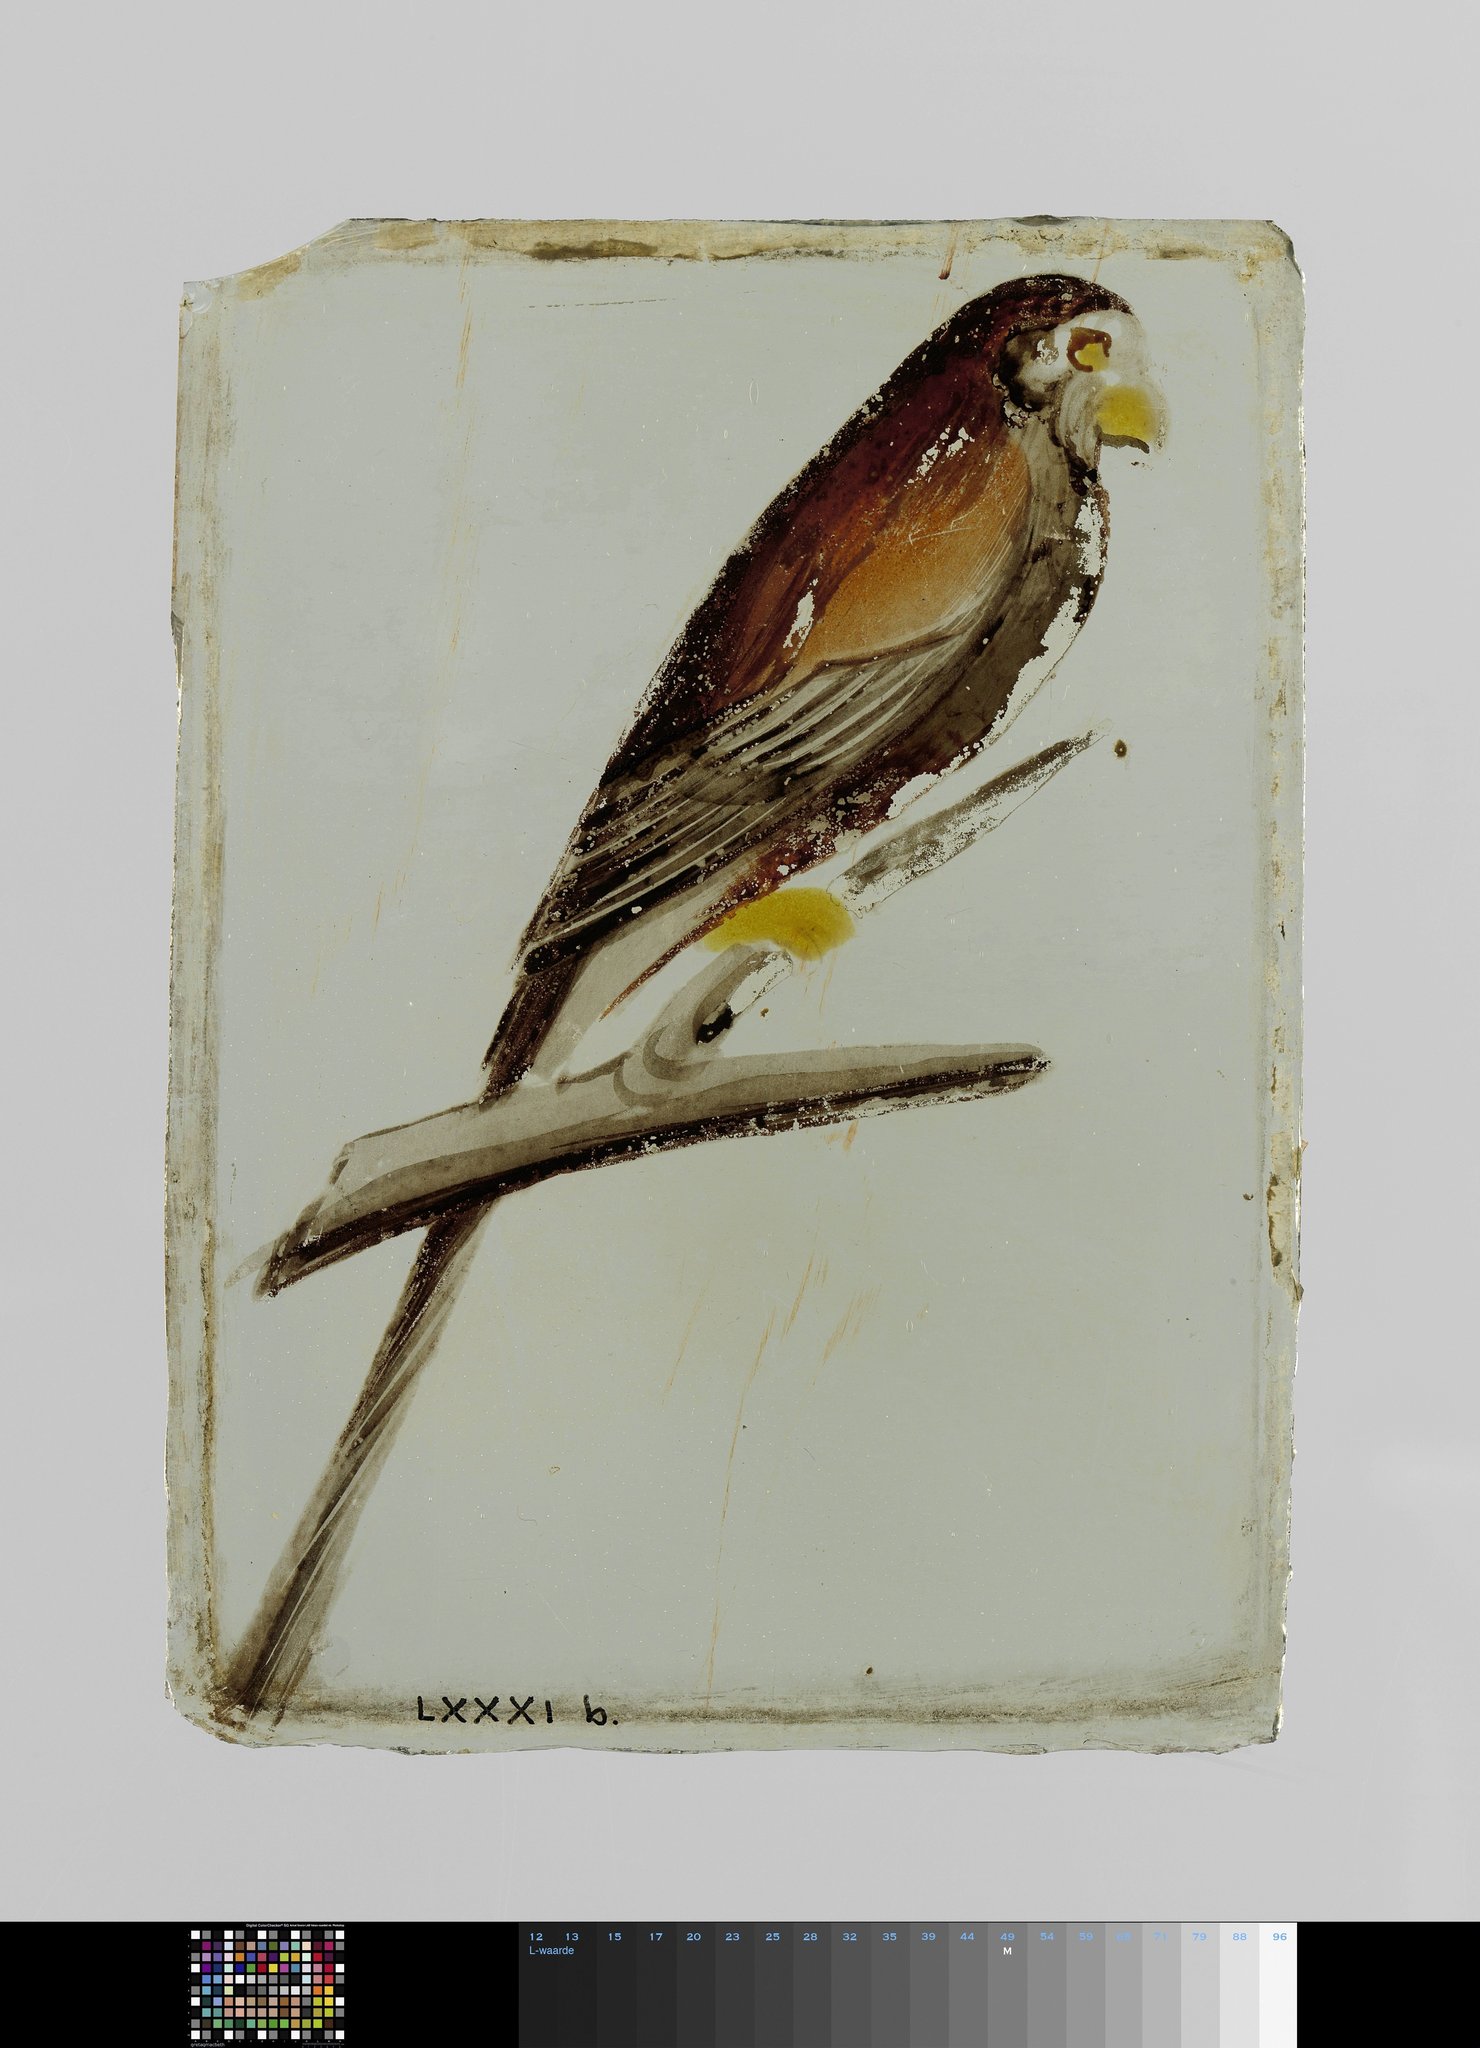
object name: light window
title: Ruit met een vogel op tak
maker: Anonymous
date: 1650-1675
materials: glass, lead, pigment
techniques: enamel painting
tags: birds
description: Ruit met emailschildering van een vogel op een tak in grisaille, oranje-rood en zilvergeel.